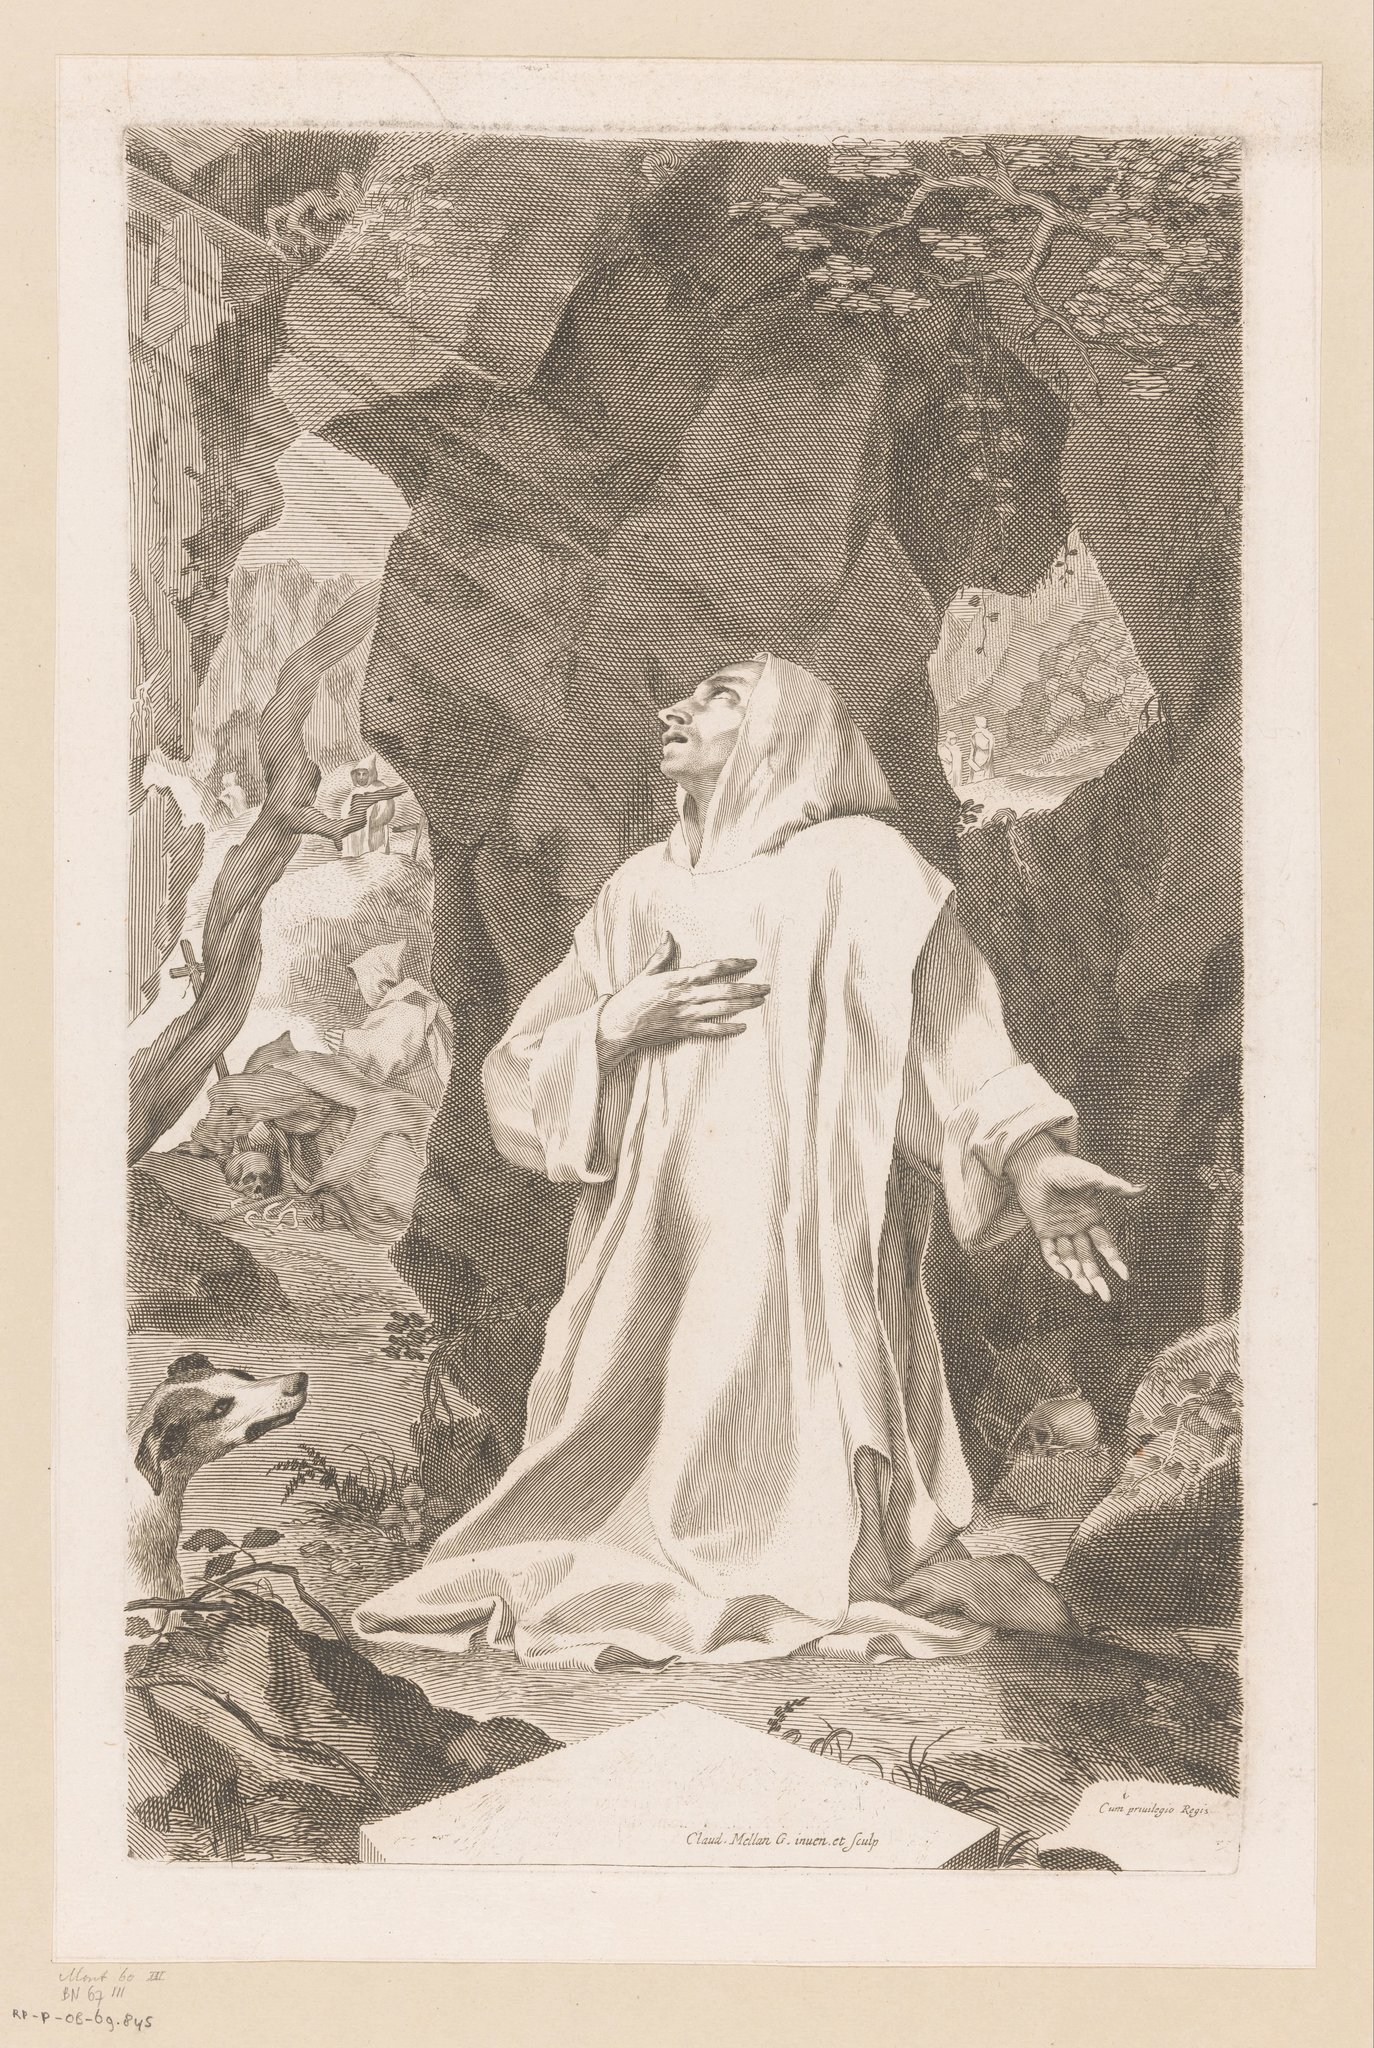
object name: print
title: H. Bruno geknield in een grot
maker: claude mellan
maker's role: draughtsman, print maker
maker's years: 1598-1688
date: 1608-1688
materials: paper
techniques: engraving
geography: france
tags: the founder of the order of the carthusians, bruno; possible attributes: cross, finger at lips, lily, mitre at his feet, olive-branch, ray of light, skull, (seven) star(s), cave, grotto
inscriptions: collector's mark: Lugt 240